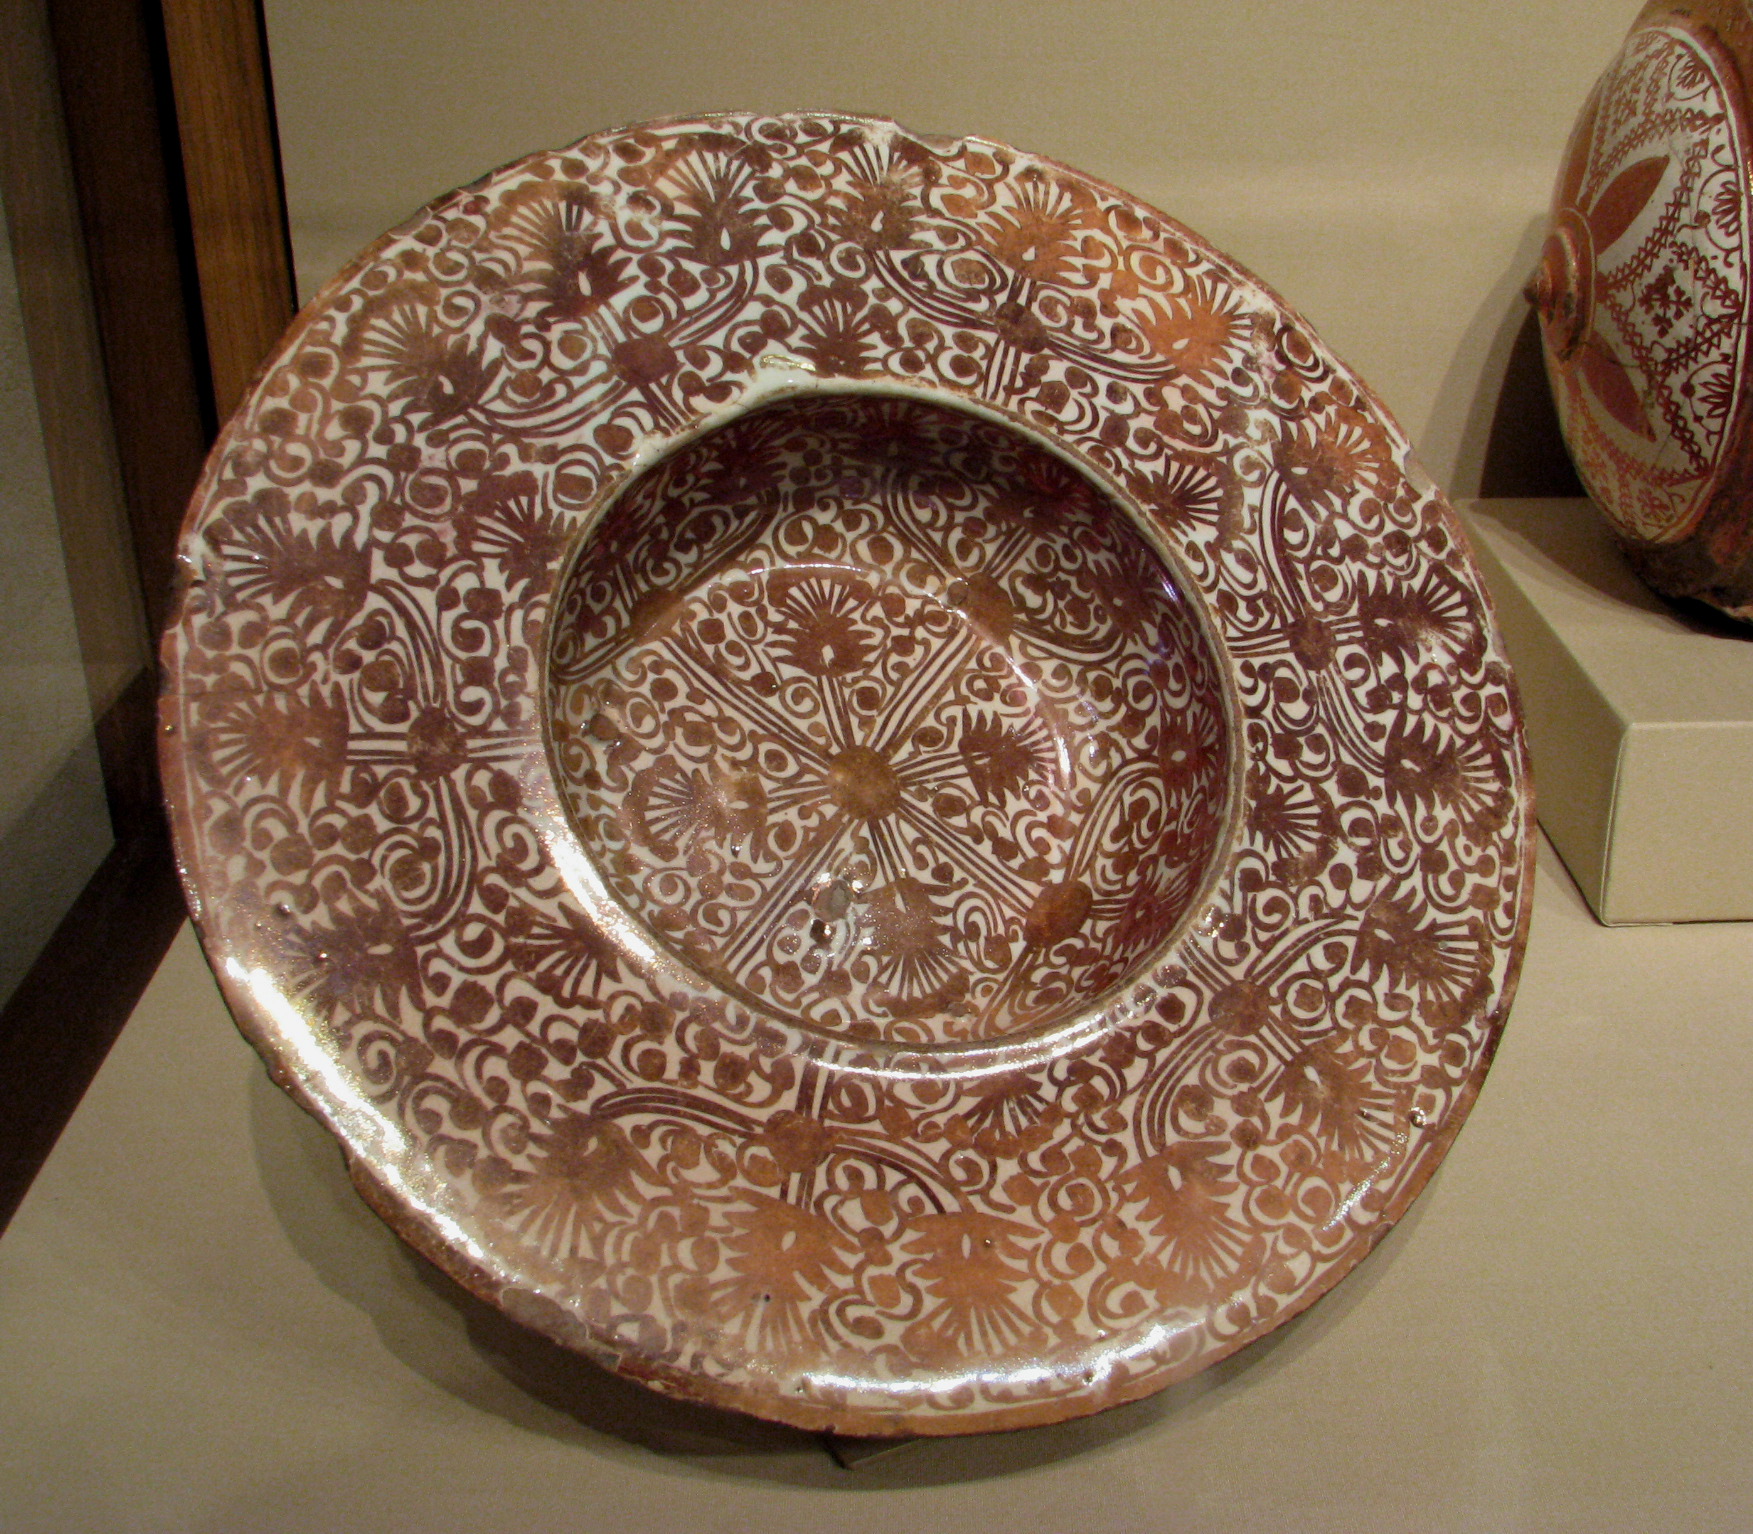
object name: bowl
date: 1501-1600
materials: earthenware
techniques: luster painting, glazing